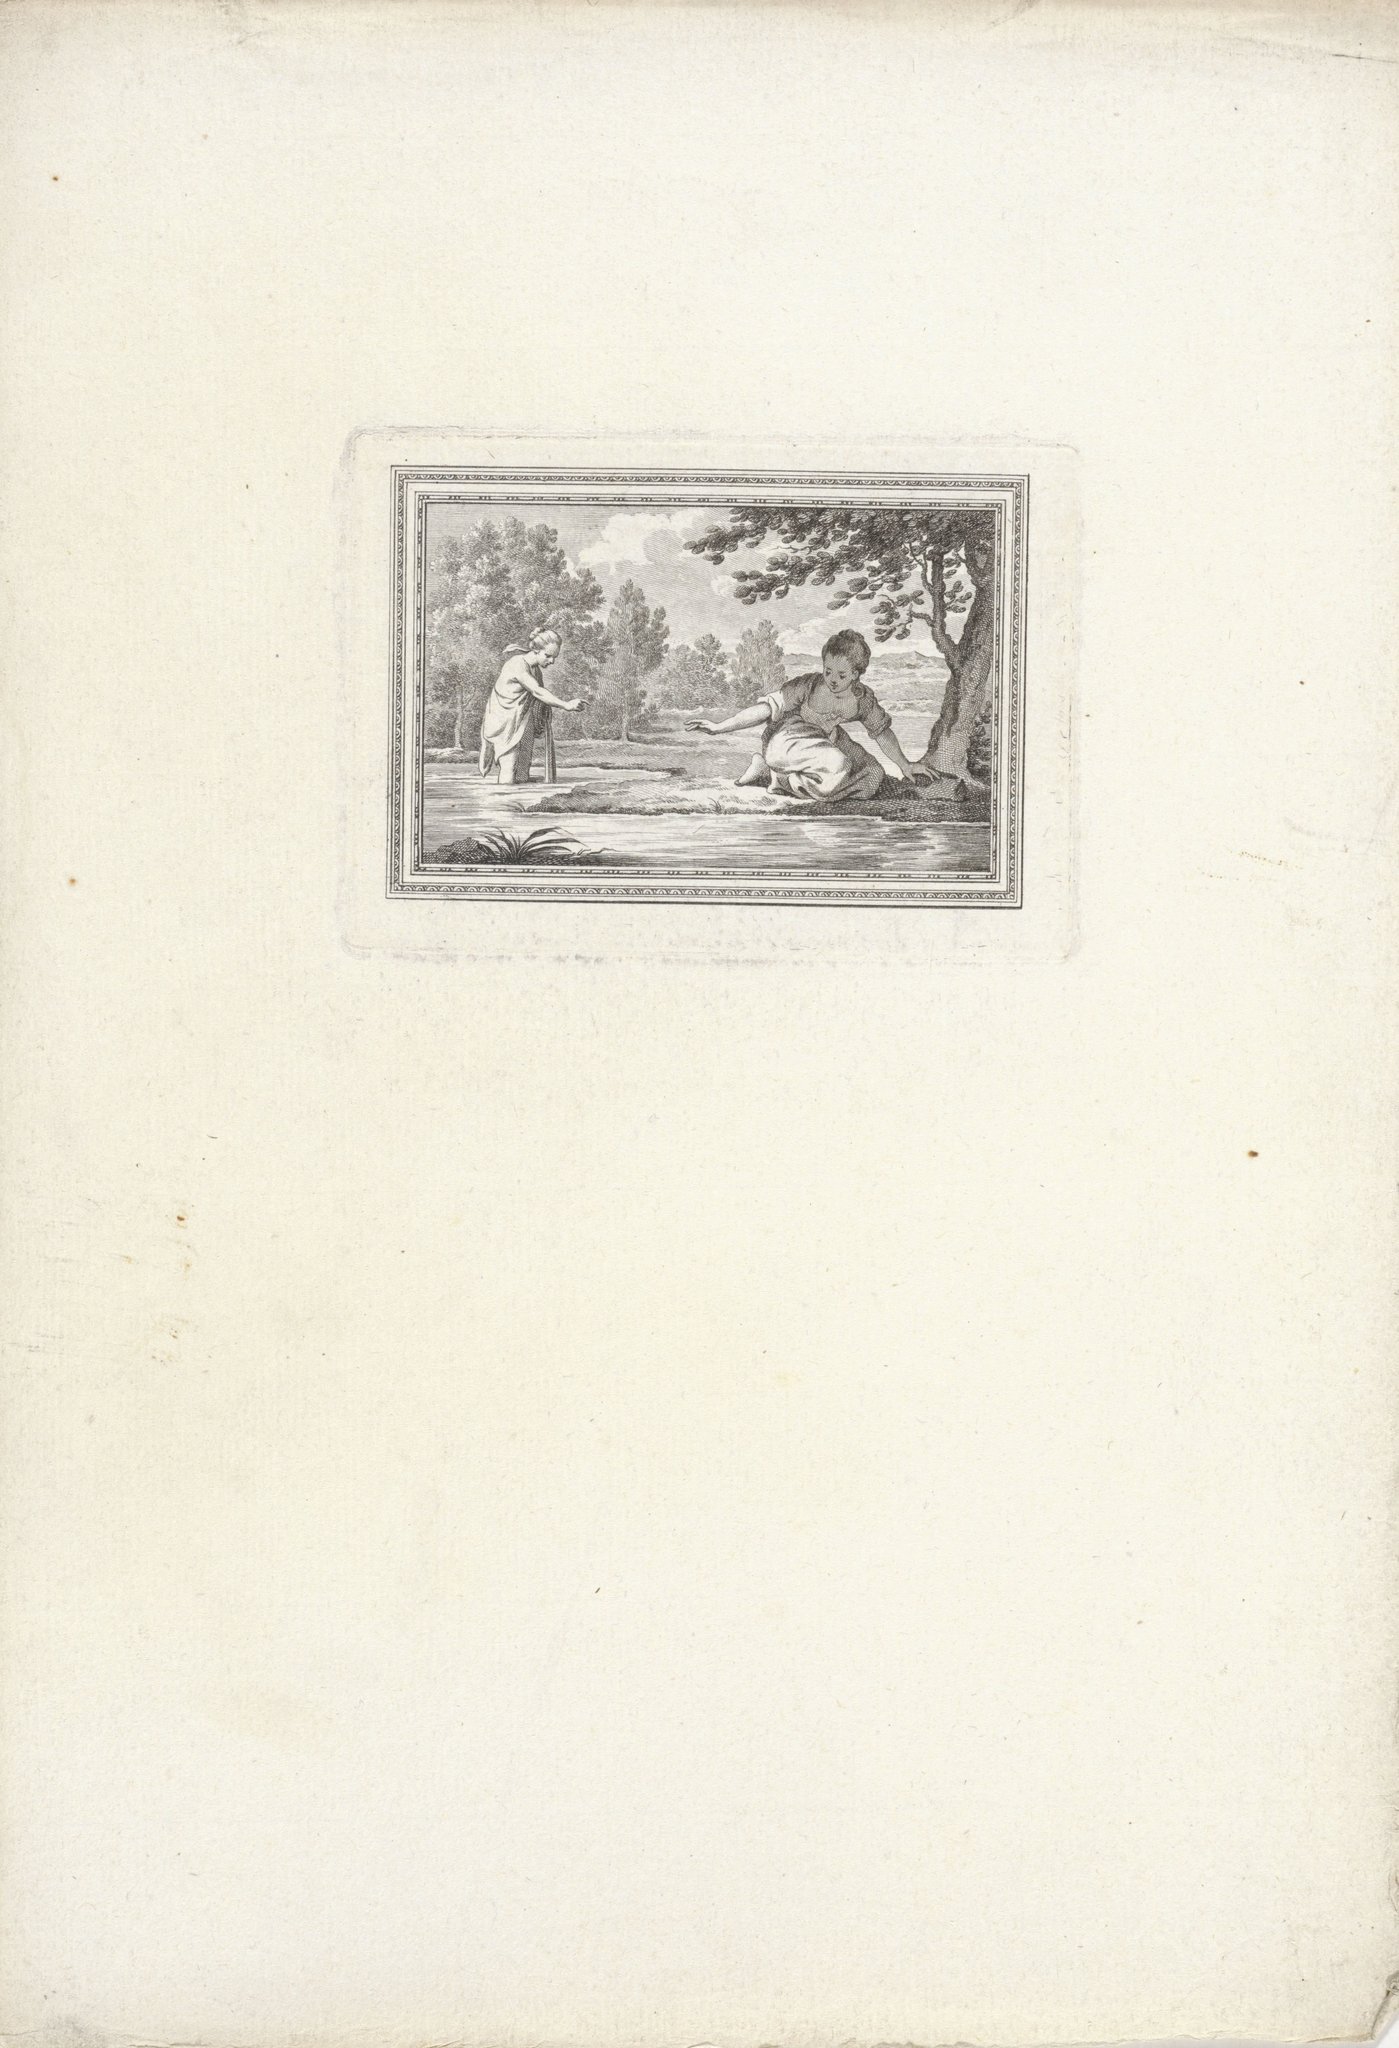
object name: book illustration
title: Jonge vrouw bekijkt haar spiegelbeeld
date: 1792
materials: paper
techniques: etching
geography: amsterdam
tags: river, reflection (in a mirror) - aa - (for) women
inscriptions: collector's mark: Lugt 2228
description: Een jonge vrouw kijkt naar haar spiegebeeld in het water, dat weldra verstoord zal worden. Illustratie bij het verhaal 'De herderin en de stroomgodes' uit 'Fabelen voor de Nederlandsche jeugd'.